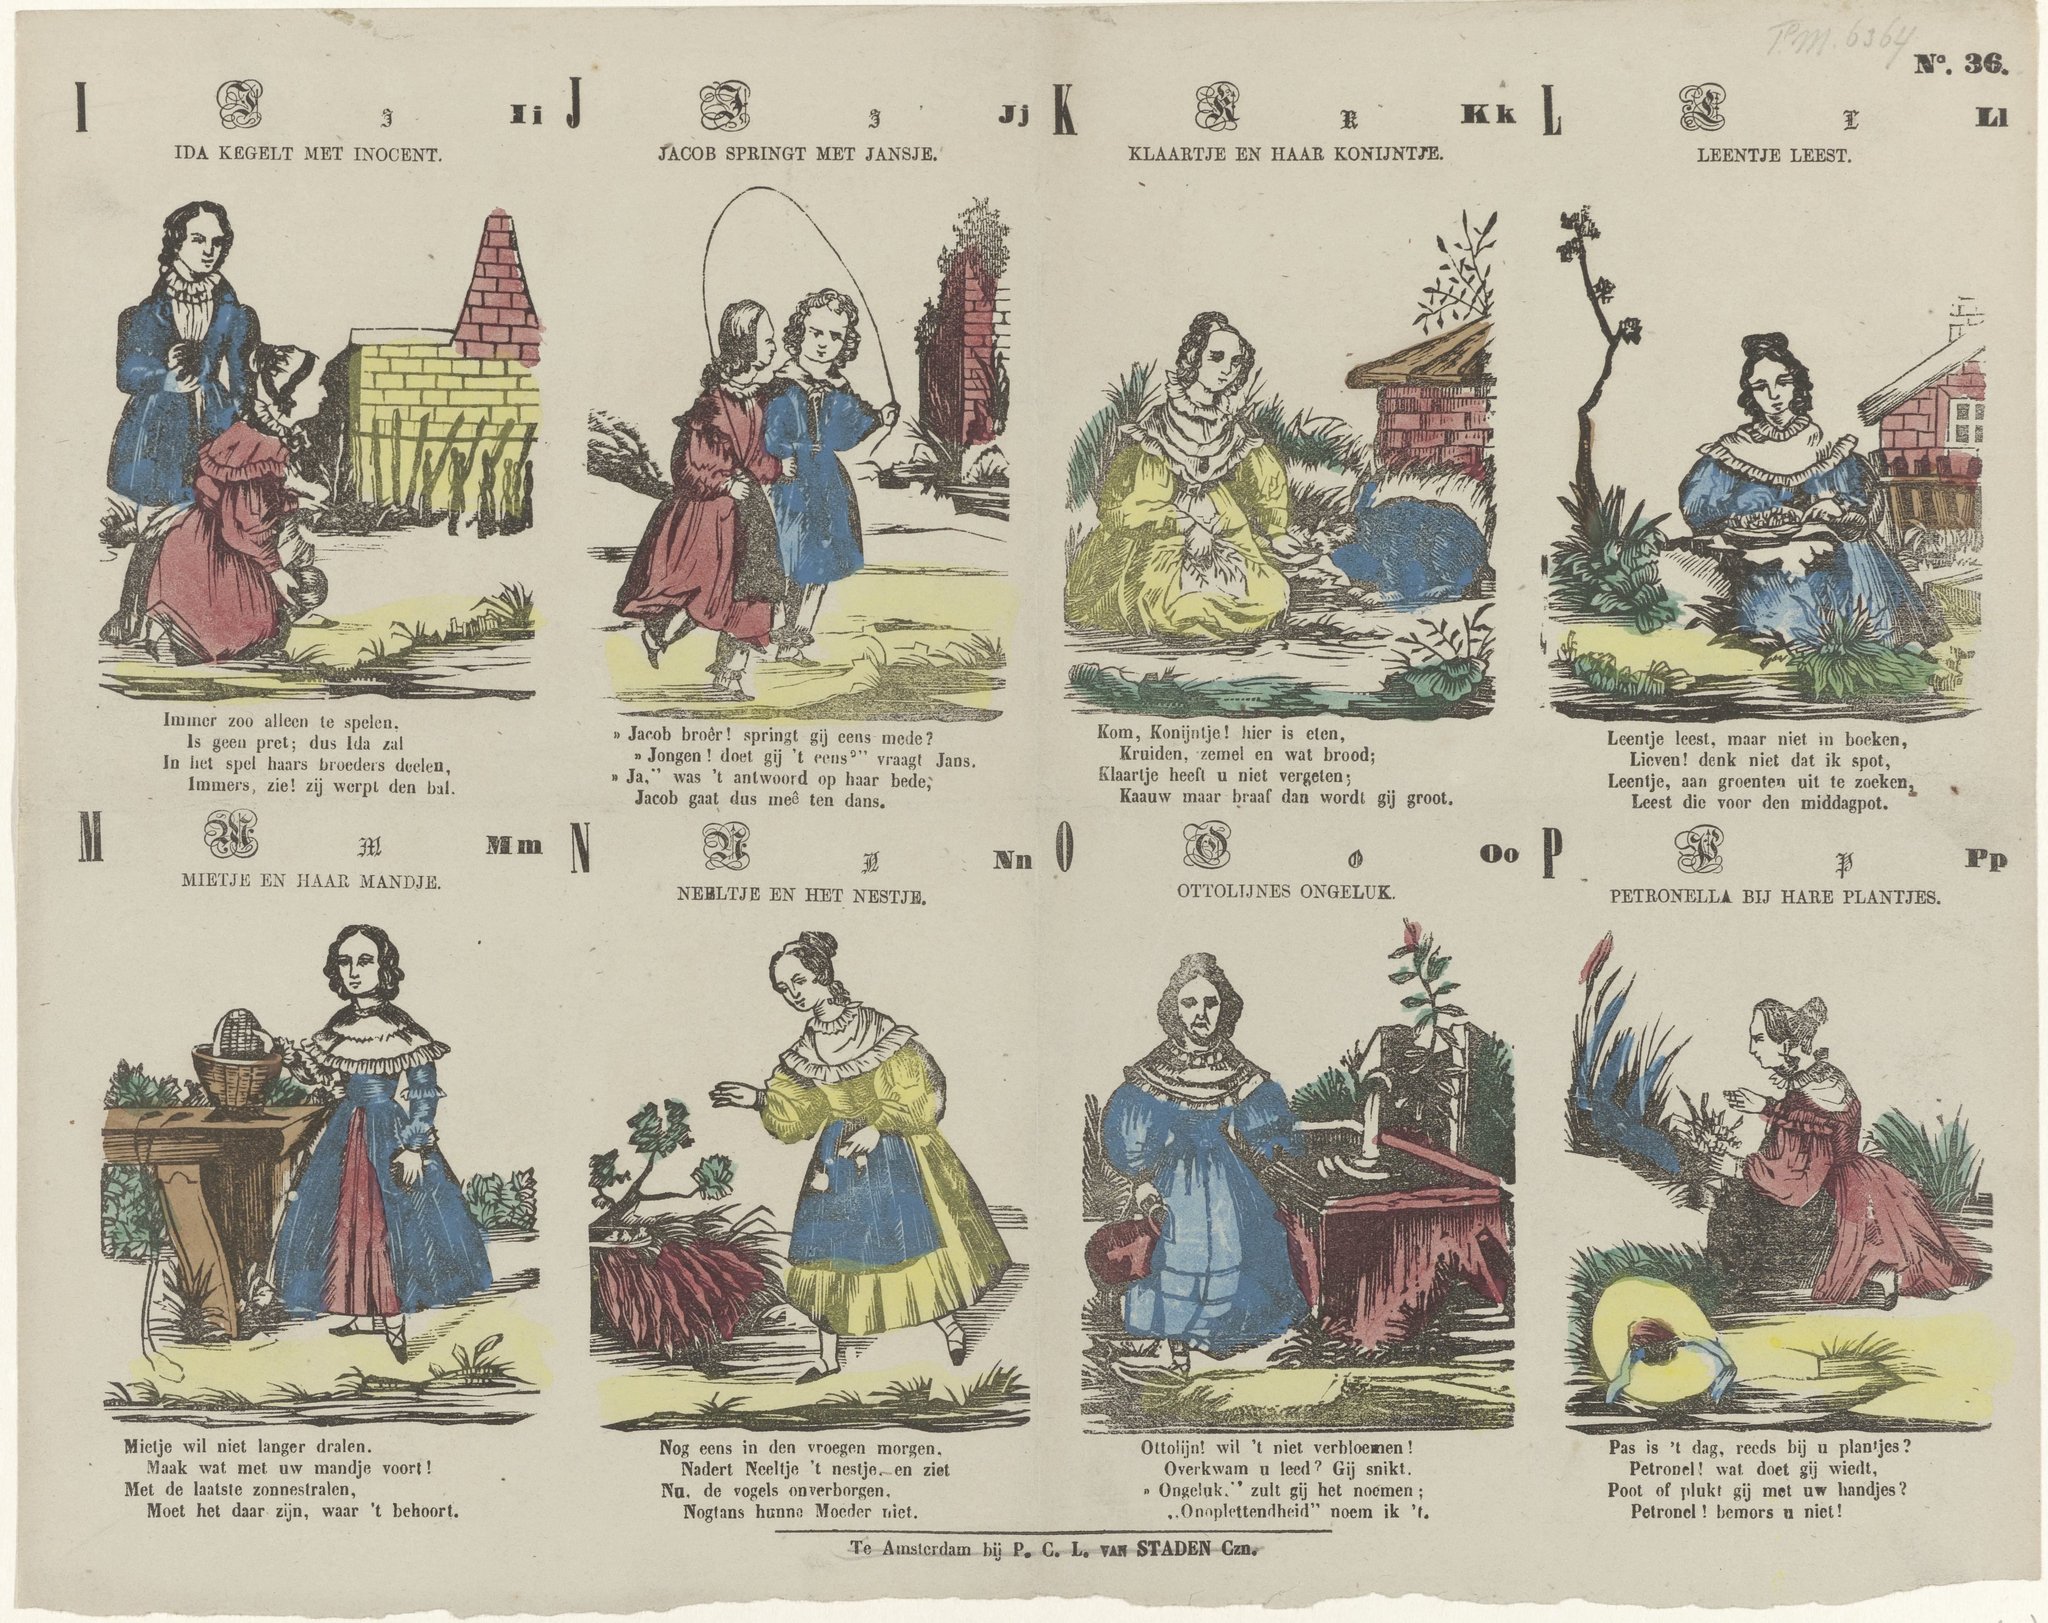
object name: print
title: ABC voor meisjes I-P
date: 1850-1870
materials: paper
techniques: colour, letterpress printing, engraving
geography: netherlands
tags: period of adolescence, adolescent, young woman, maiden, children's games and plays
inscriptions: collector's mark: Lugt 2228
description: Blad met acht voorstellingen uit een ABC van het meisjesleven, voor de letters I-P, bij elk letter een meisjesnaam. Onder elk plaatje een vierregelig versje. Genummerd rechtsboven: No. 36. Ca. 1800-1850.